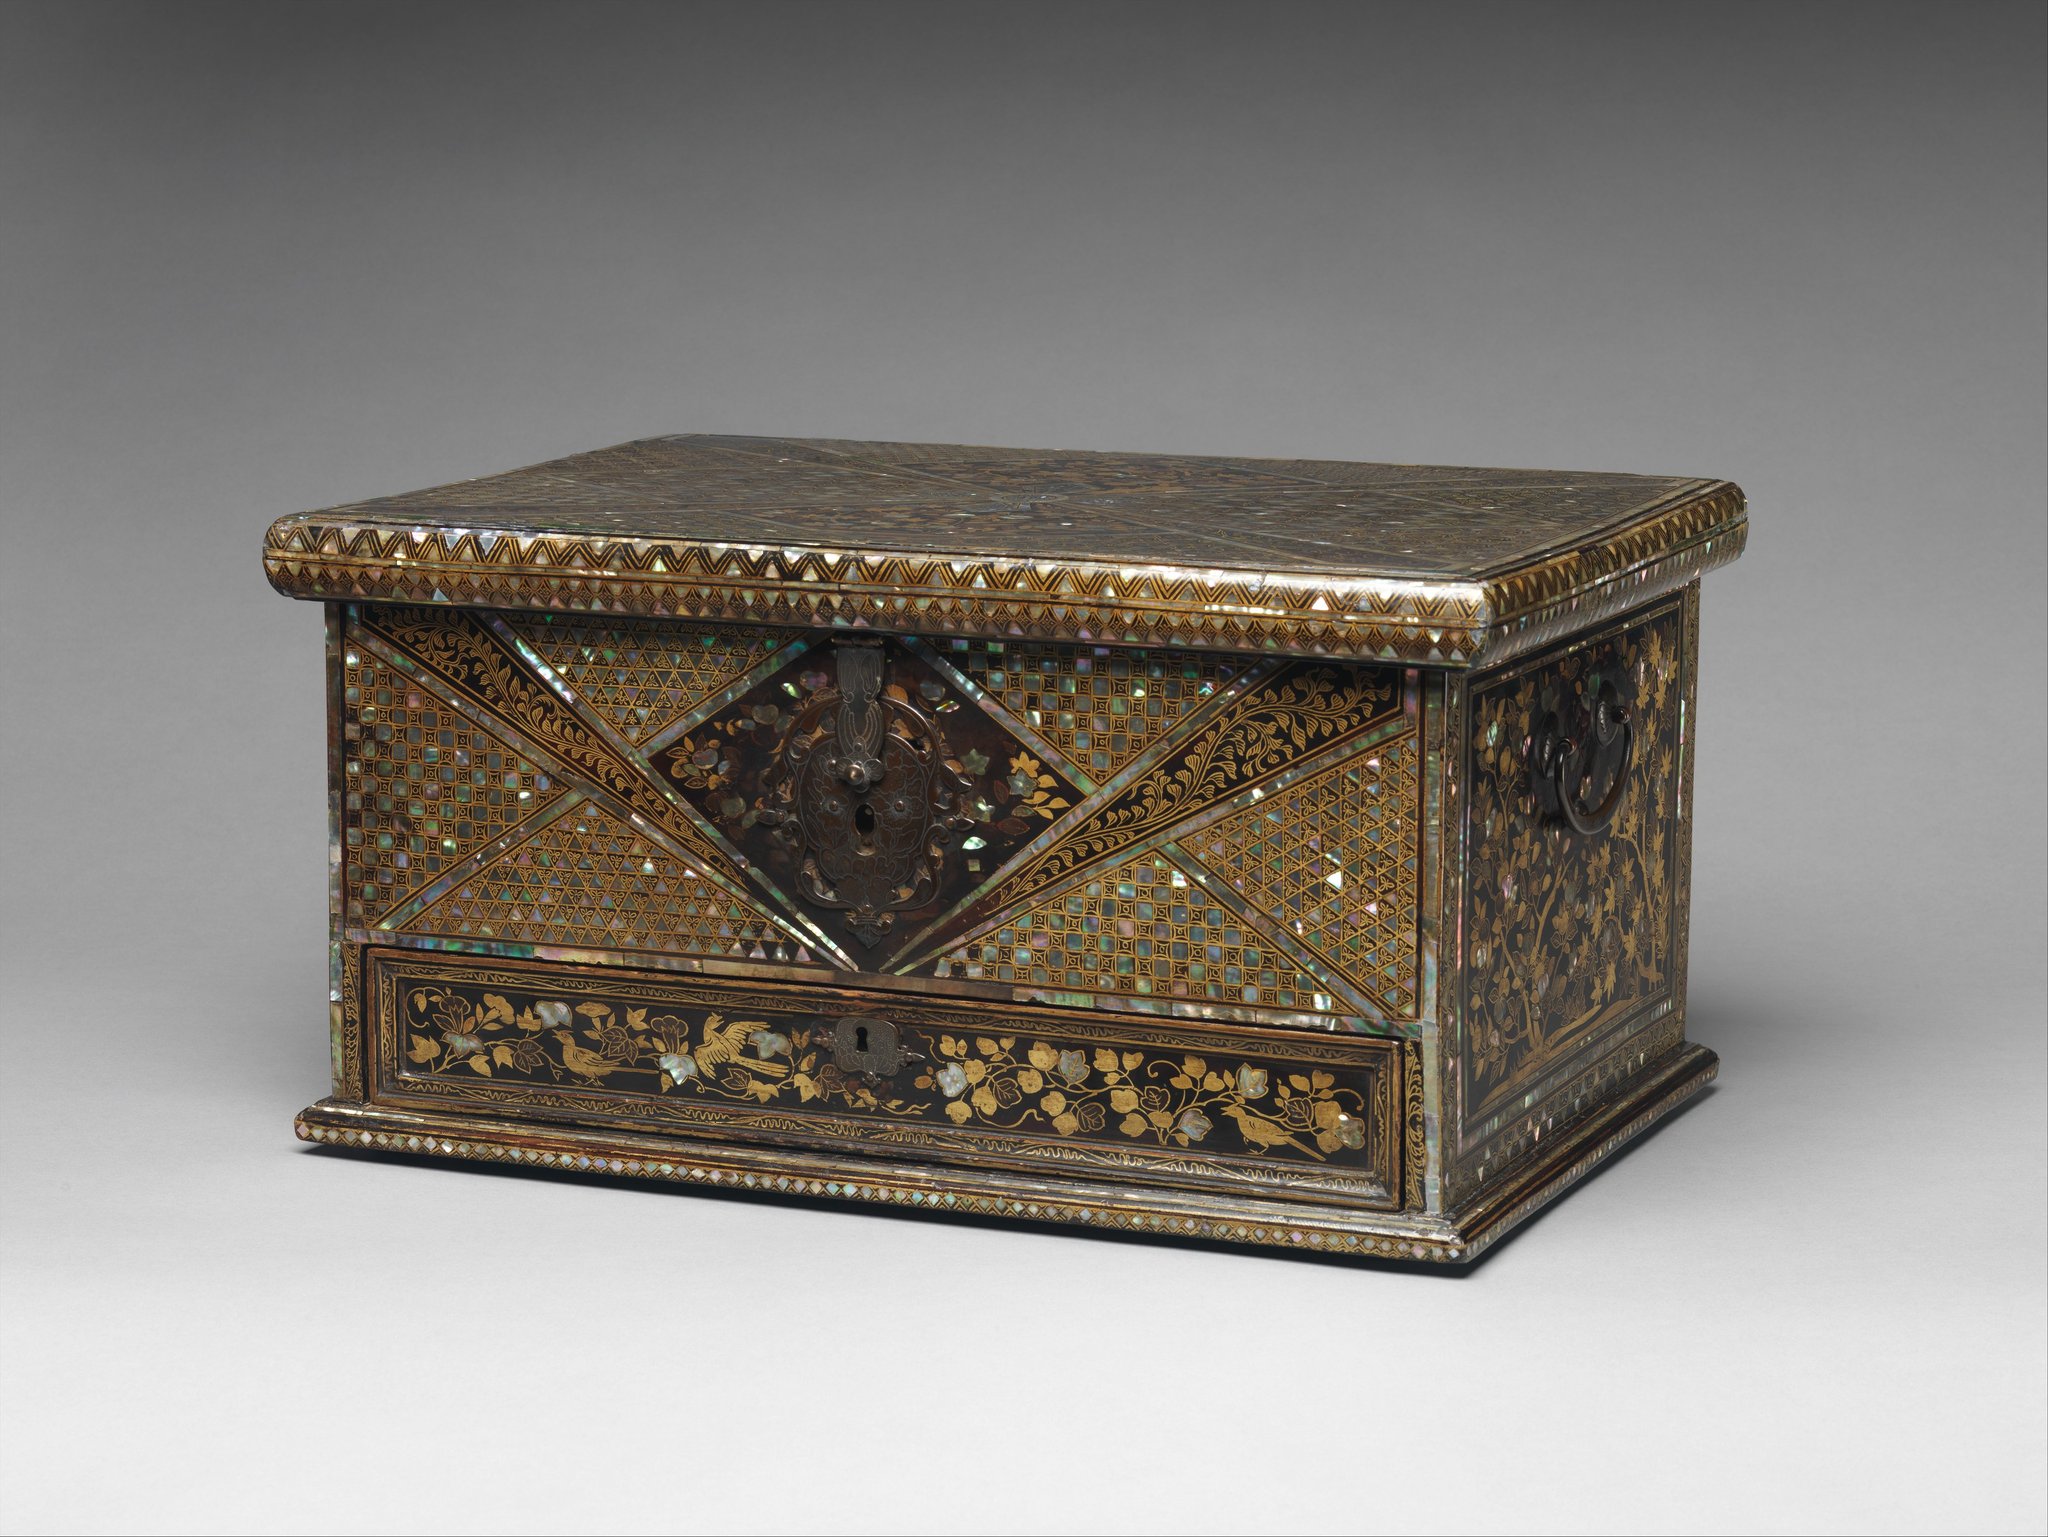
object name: chest of drawer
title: Chest with a Single Drawer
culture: japanese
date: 1567-1633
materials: copper gilt, gold, lacquer, mother of pearl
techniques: hiramakie, inlay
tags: birds,leaves,chests